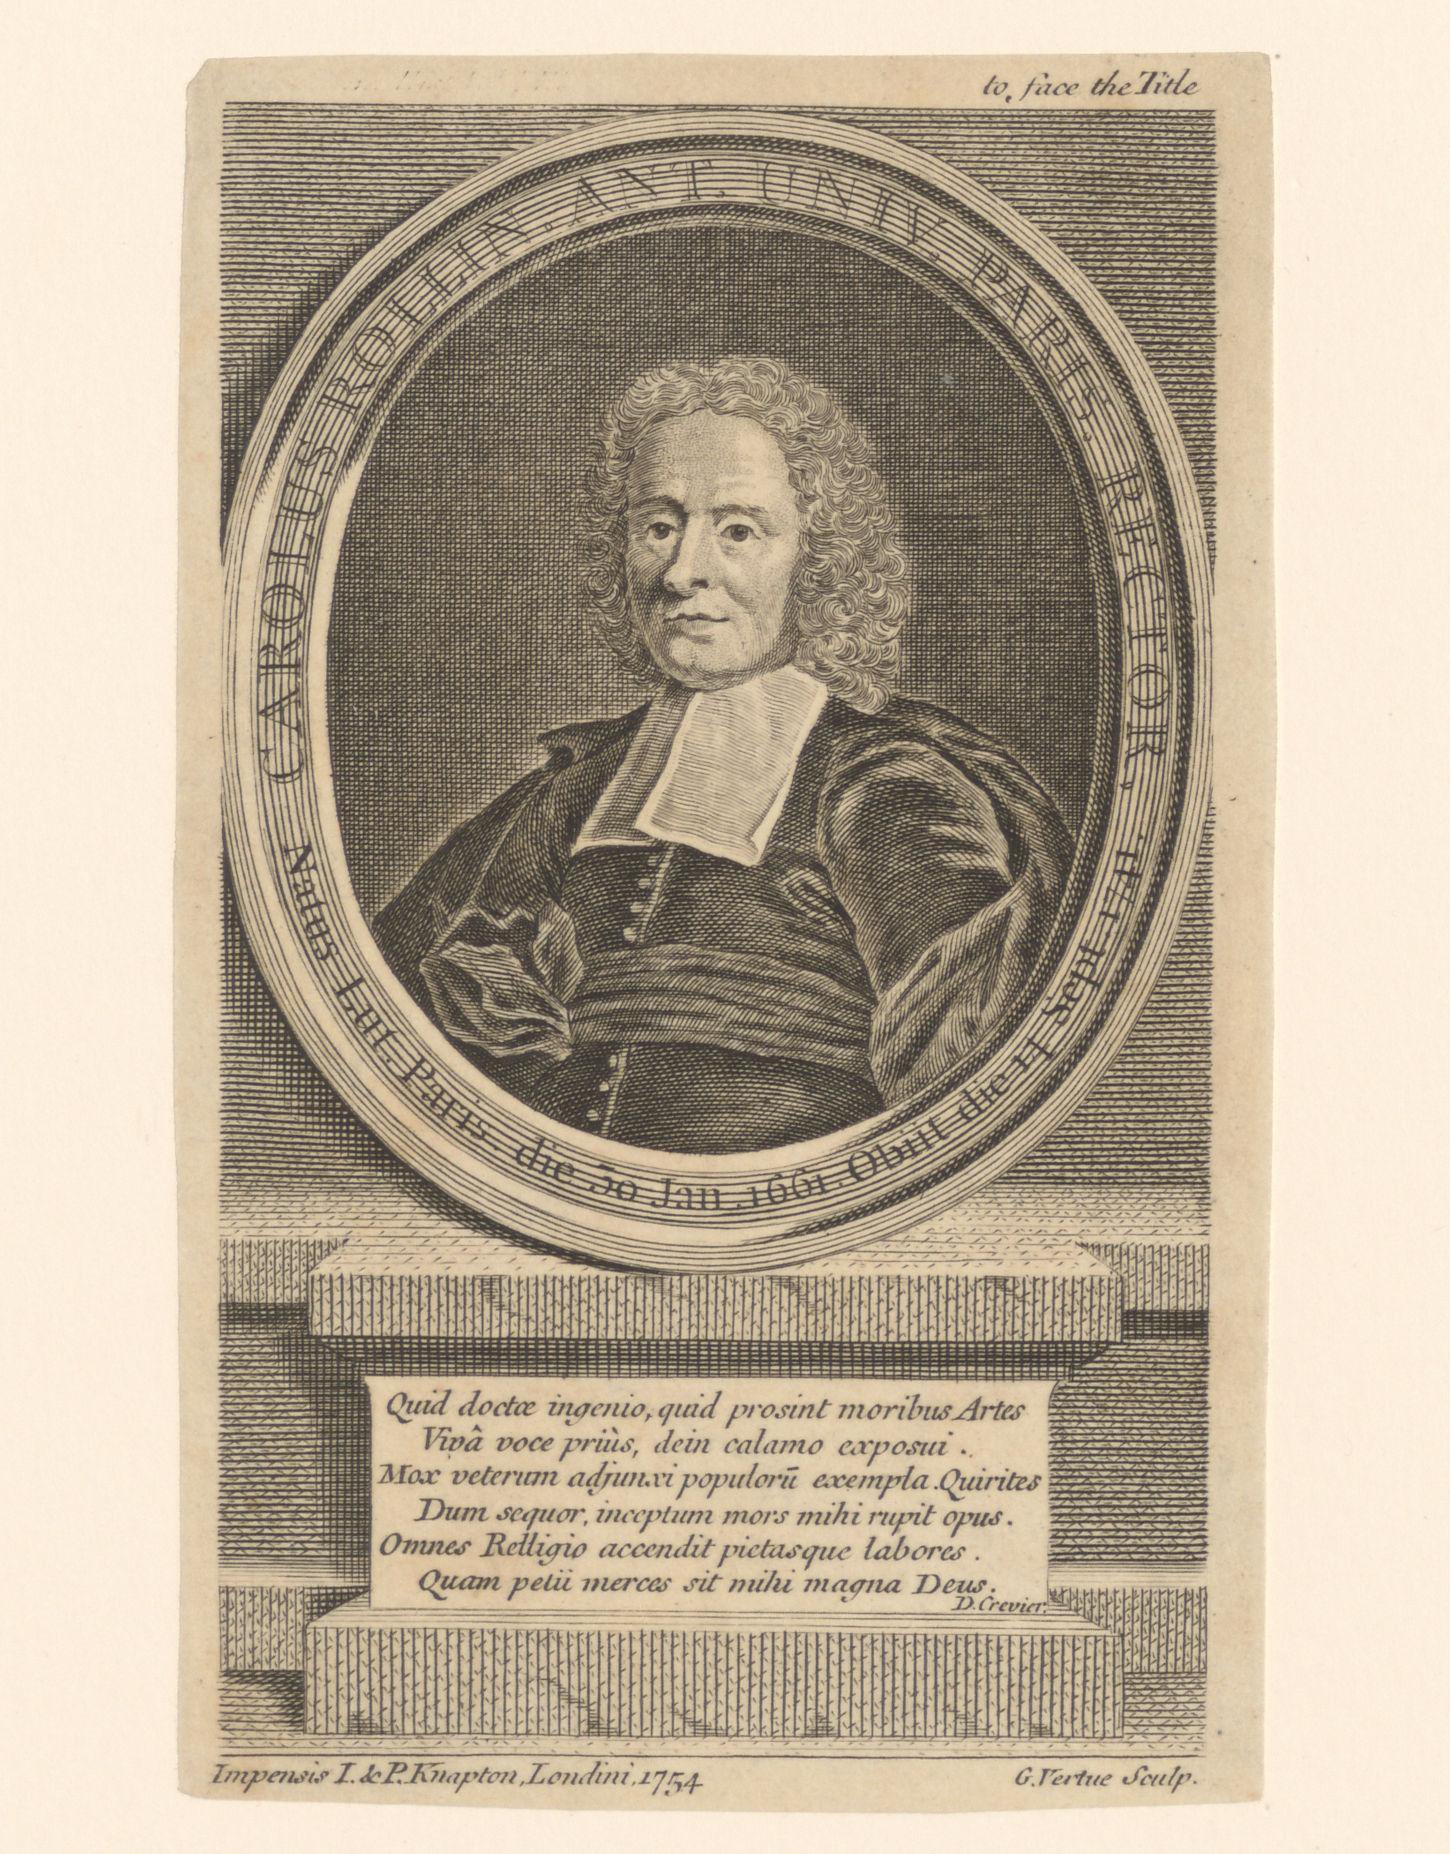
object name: print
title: Portret van Charles Rollin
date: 1754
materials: paper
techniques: engraving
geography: london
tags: charles rollin, historical persons, portrait of a writer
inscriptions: collector's mark: Lugt 2228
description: Tekst in het Latijn in de omlijsting en op de sokkel.